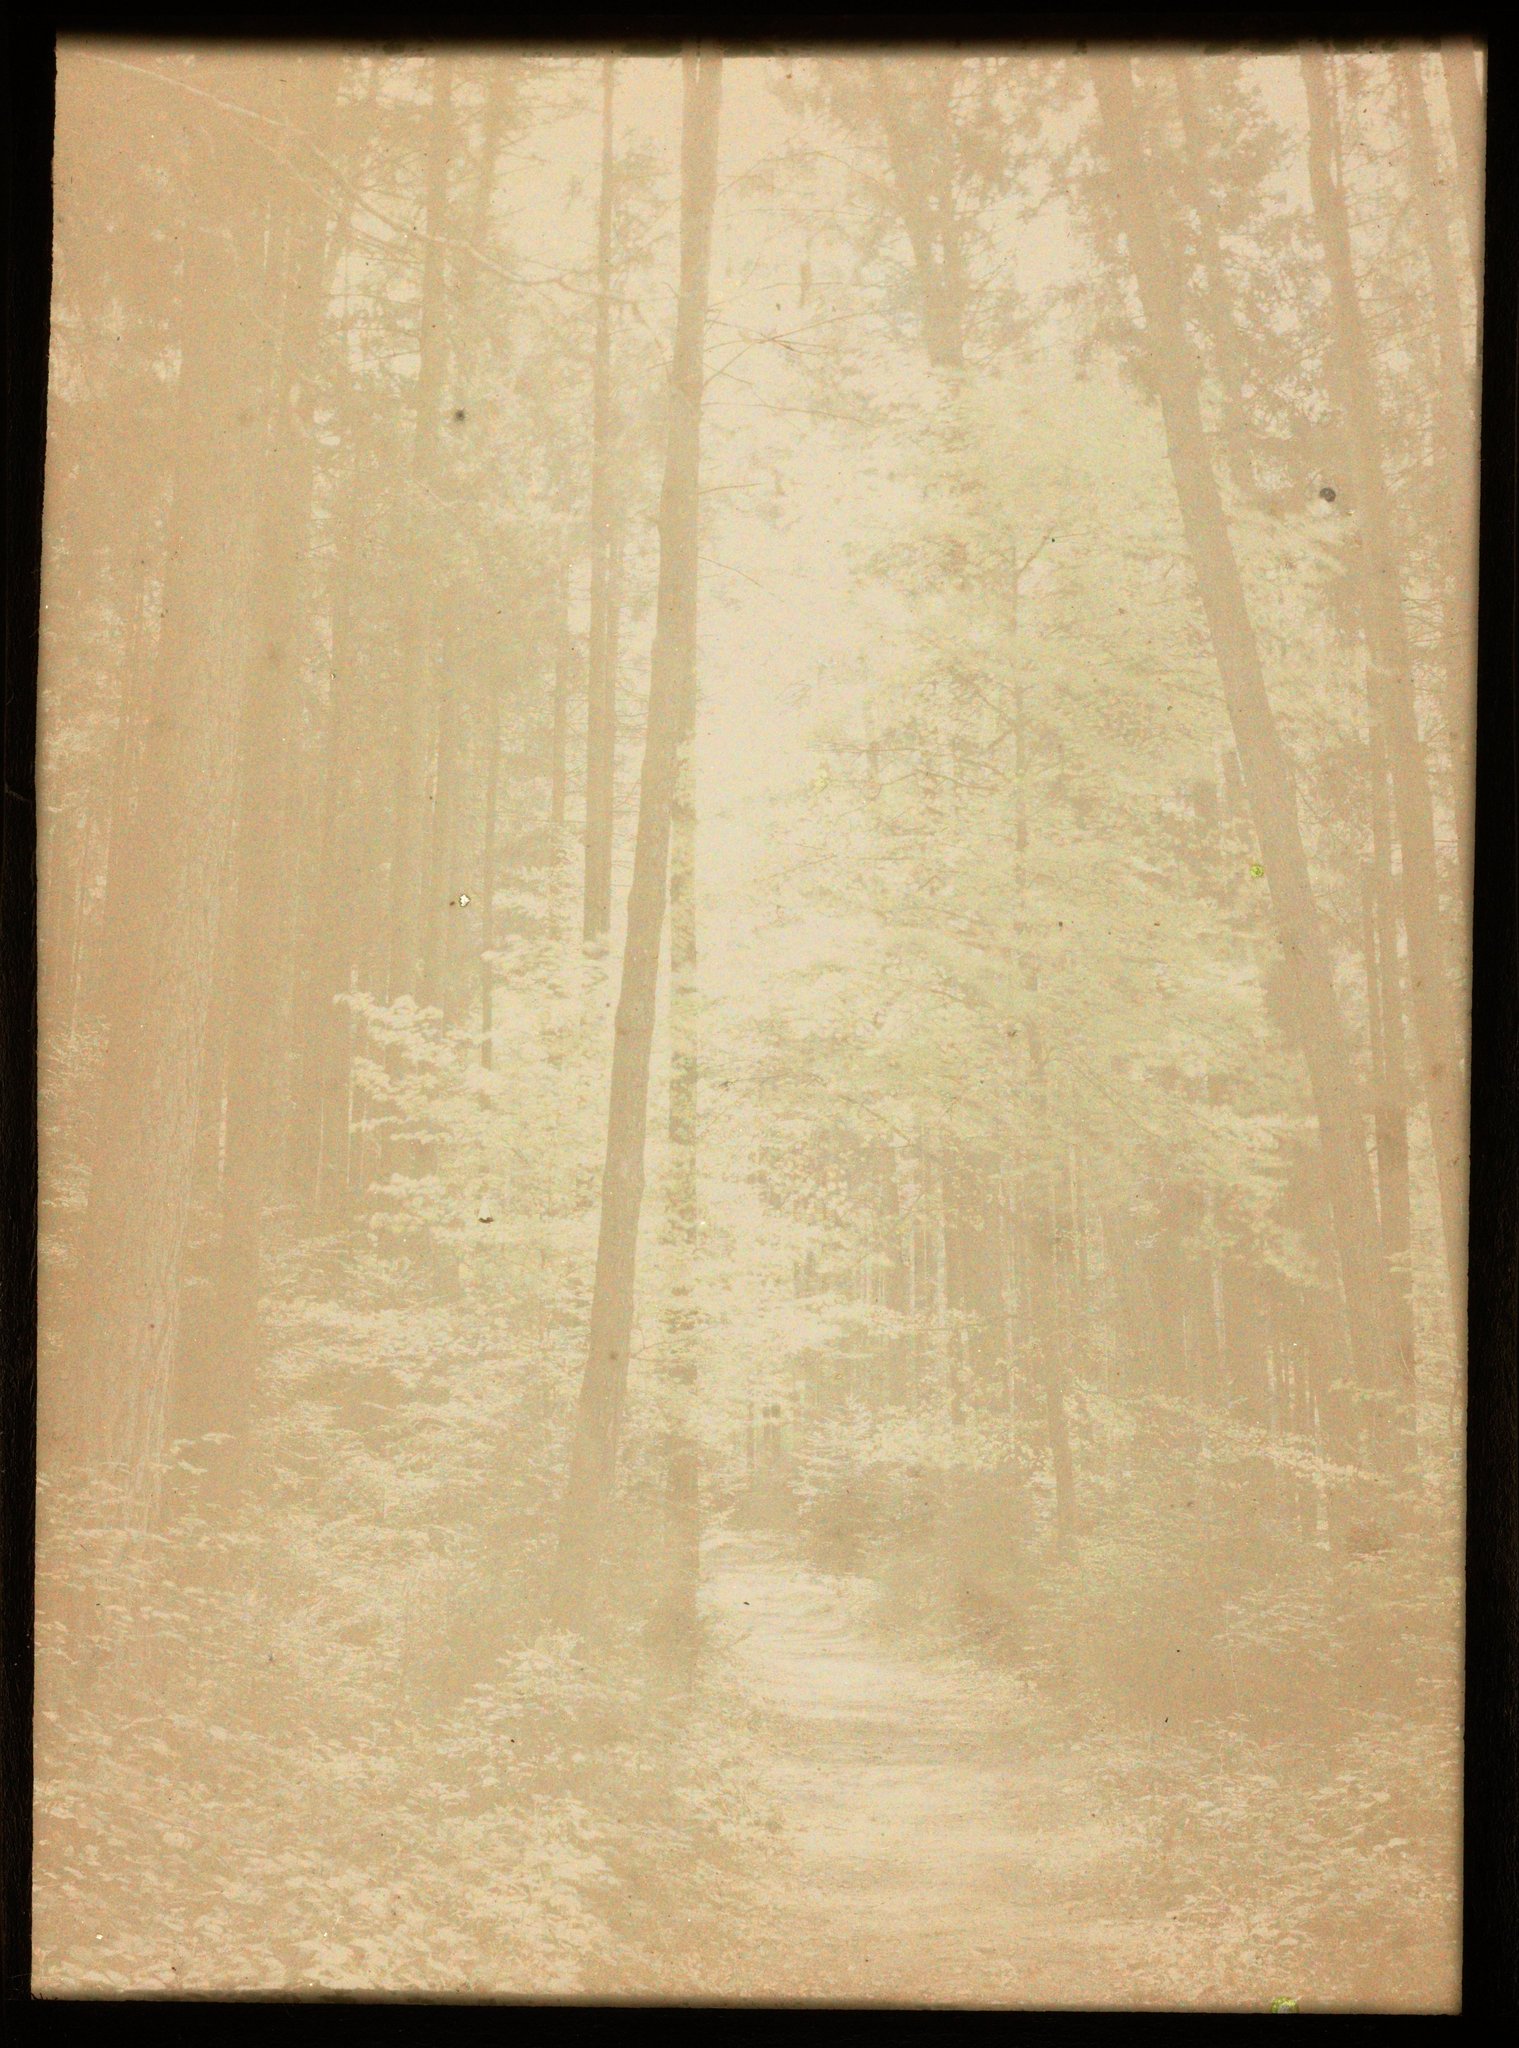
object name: glasdia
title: Gezicht in een bos, met bomen aan weerszijden van een pad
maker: adolphe burdet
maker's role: fotograaf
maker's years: 1860-1940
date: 1907-1930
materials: glass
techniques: autochrome process, slide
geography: netherlands